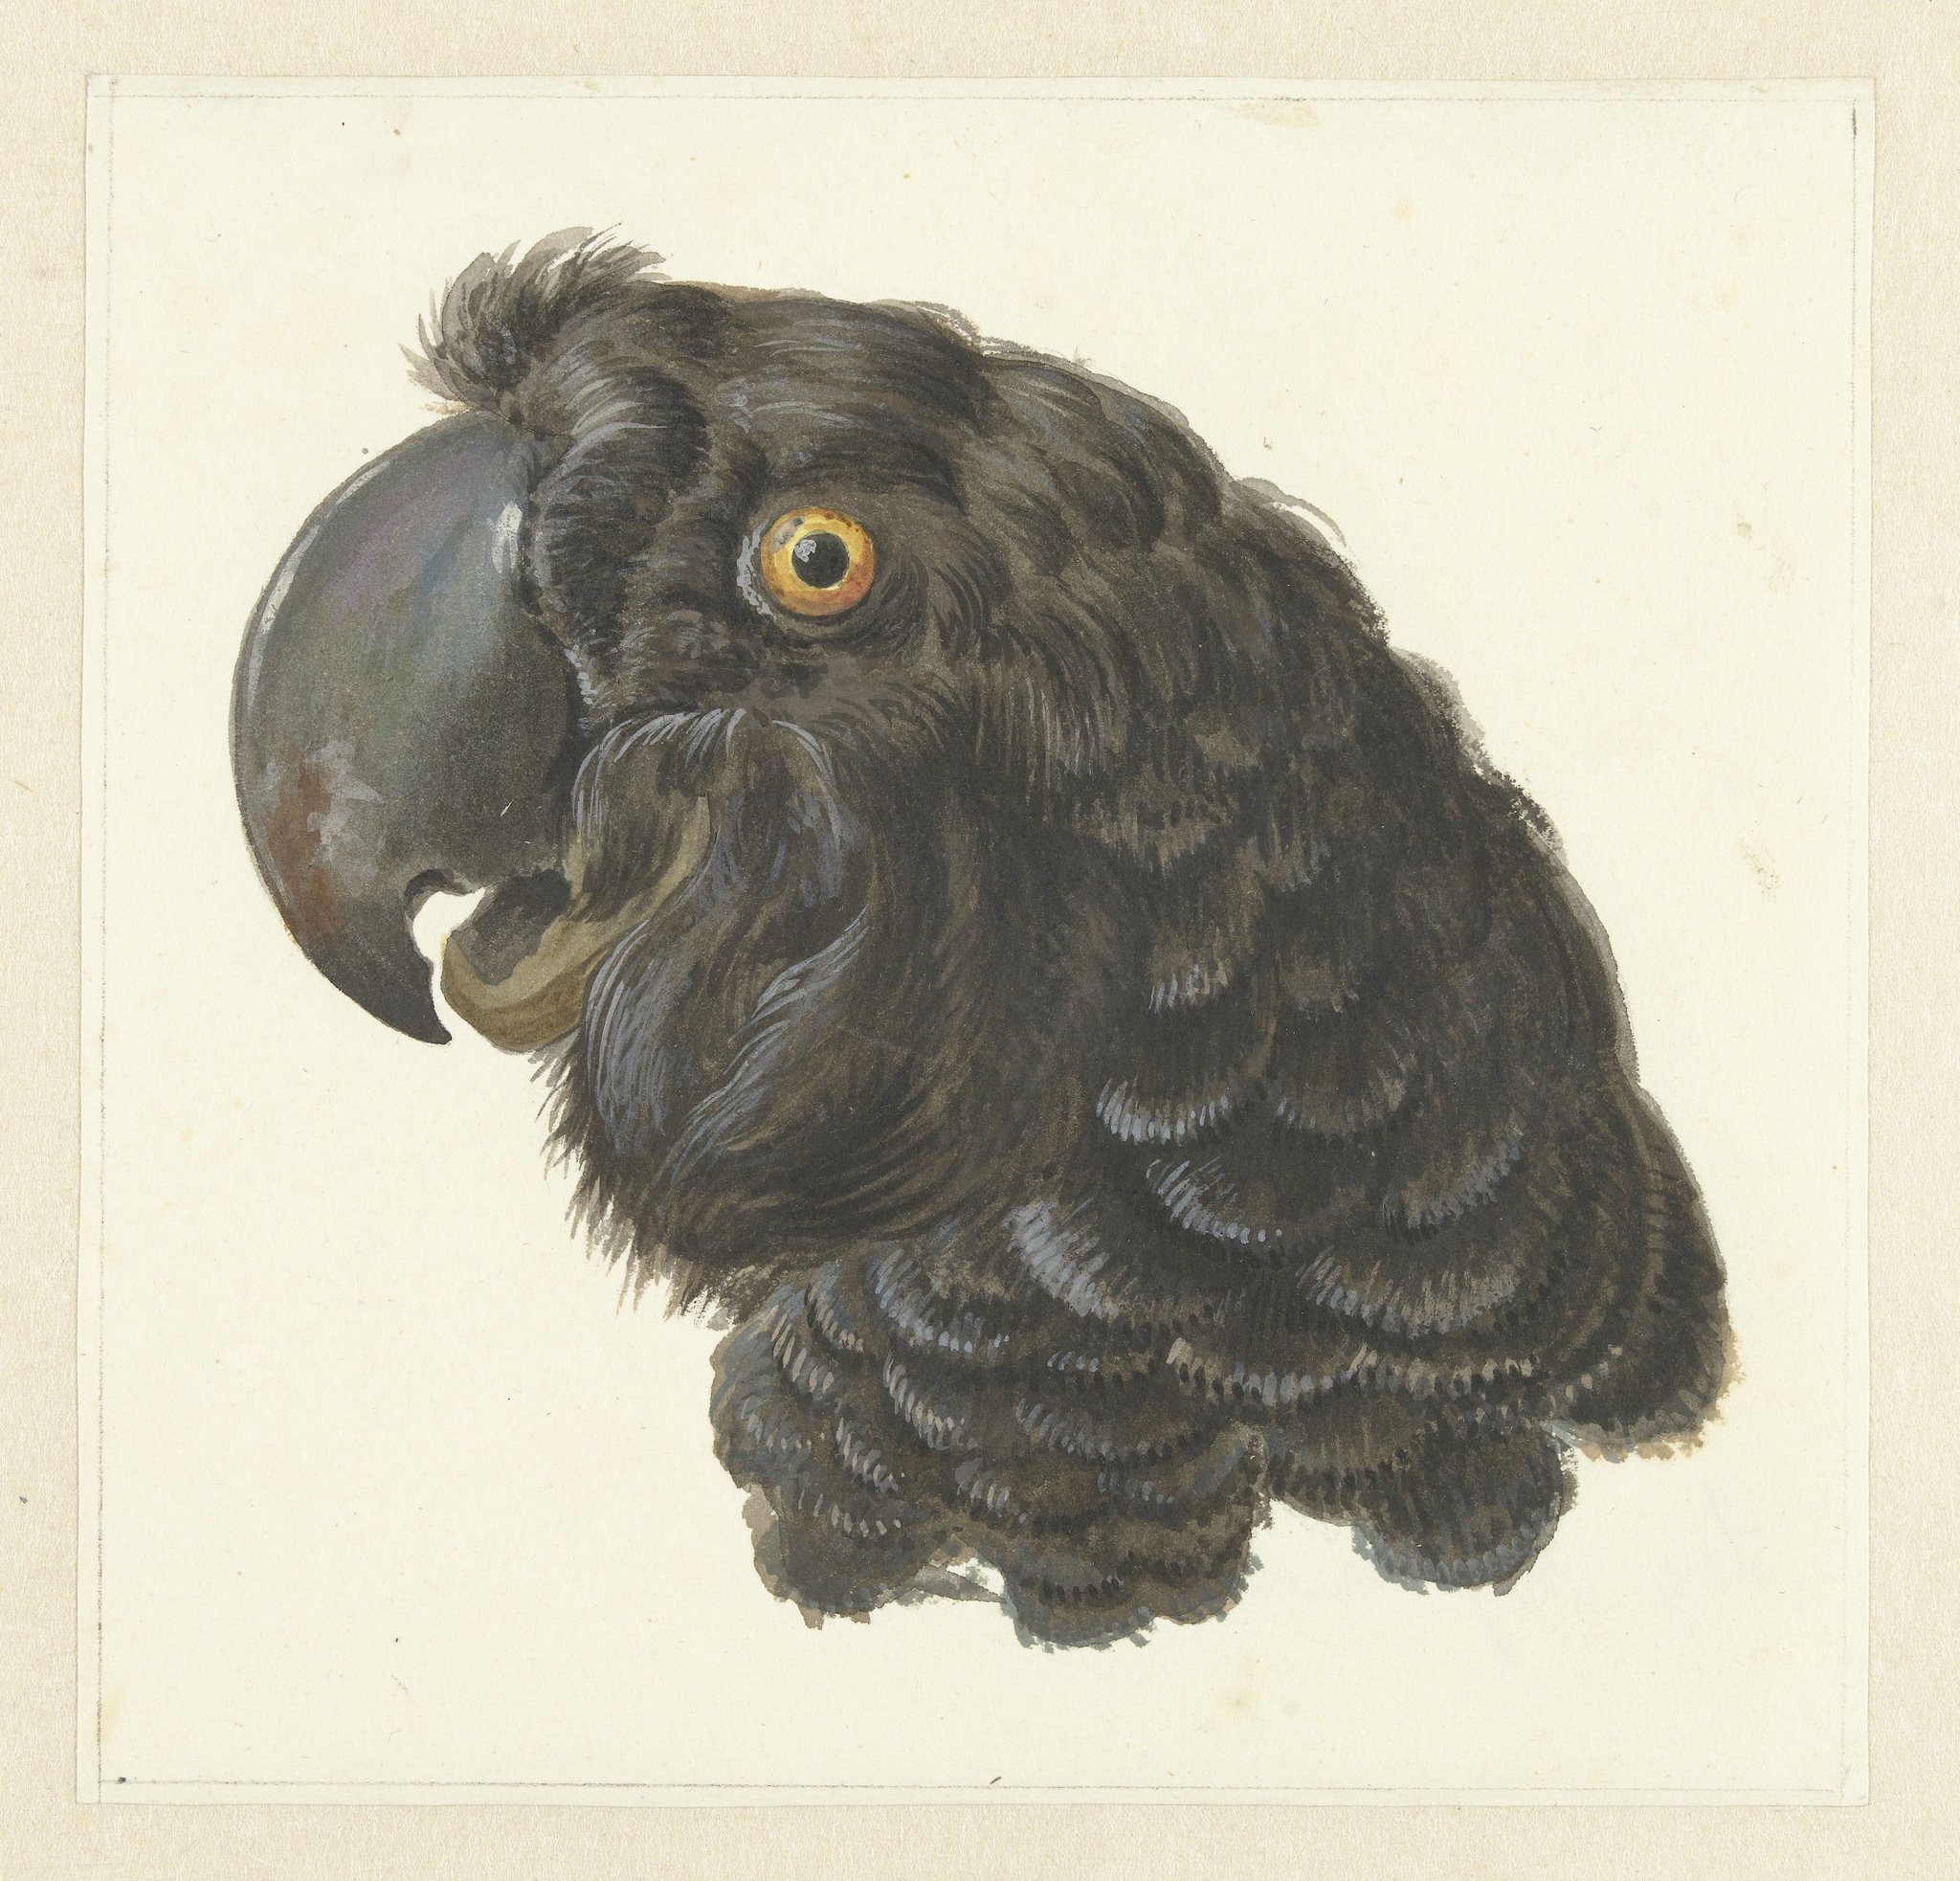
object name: drawing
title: Head of a Cockatoo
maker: aert schouman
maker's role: draughtsman, painter, print maker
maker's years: 1710-1792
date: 1725-1792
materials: paper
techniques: aquarelle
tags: ornamental birds: cockatoo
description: RP-T-1905-220 t/m 254: Vijfendertig Tekeningen met verschillende vogel- en apensoorten. Op één ervan: Histoire naturelle de viseaux d'Afrique par Francóis Le voillant Exemple. soignees.